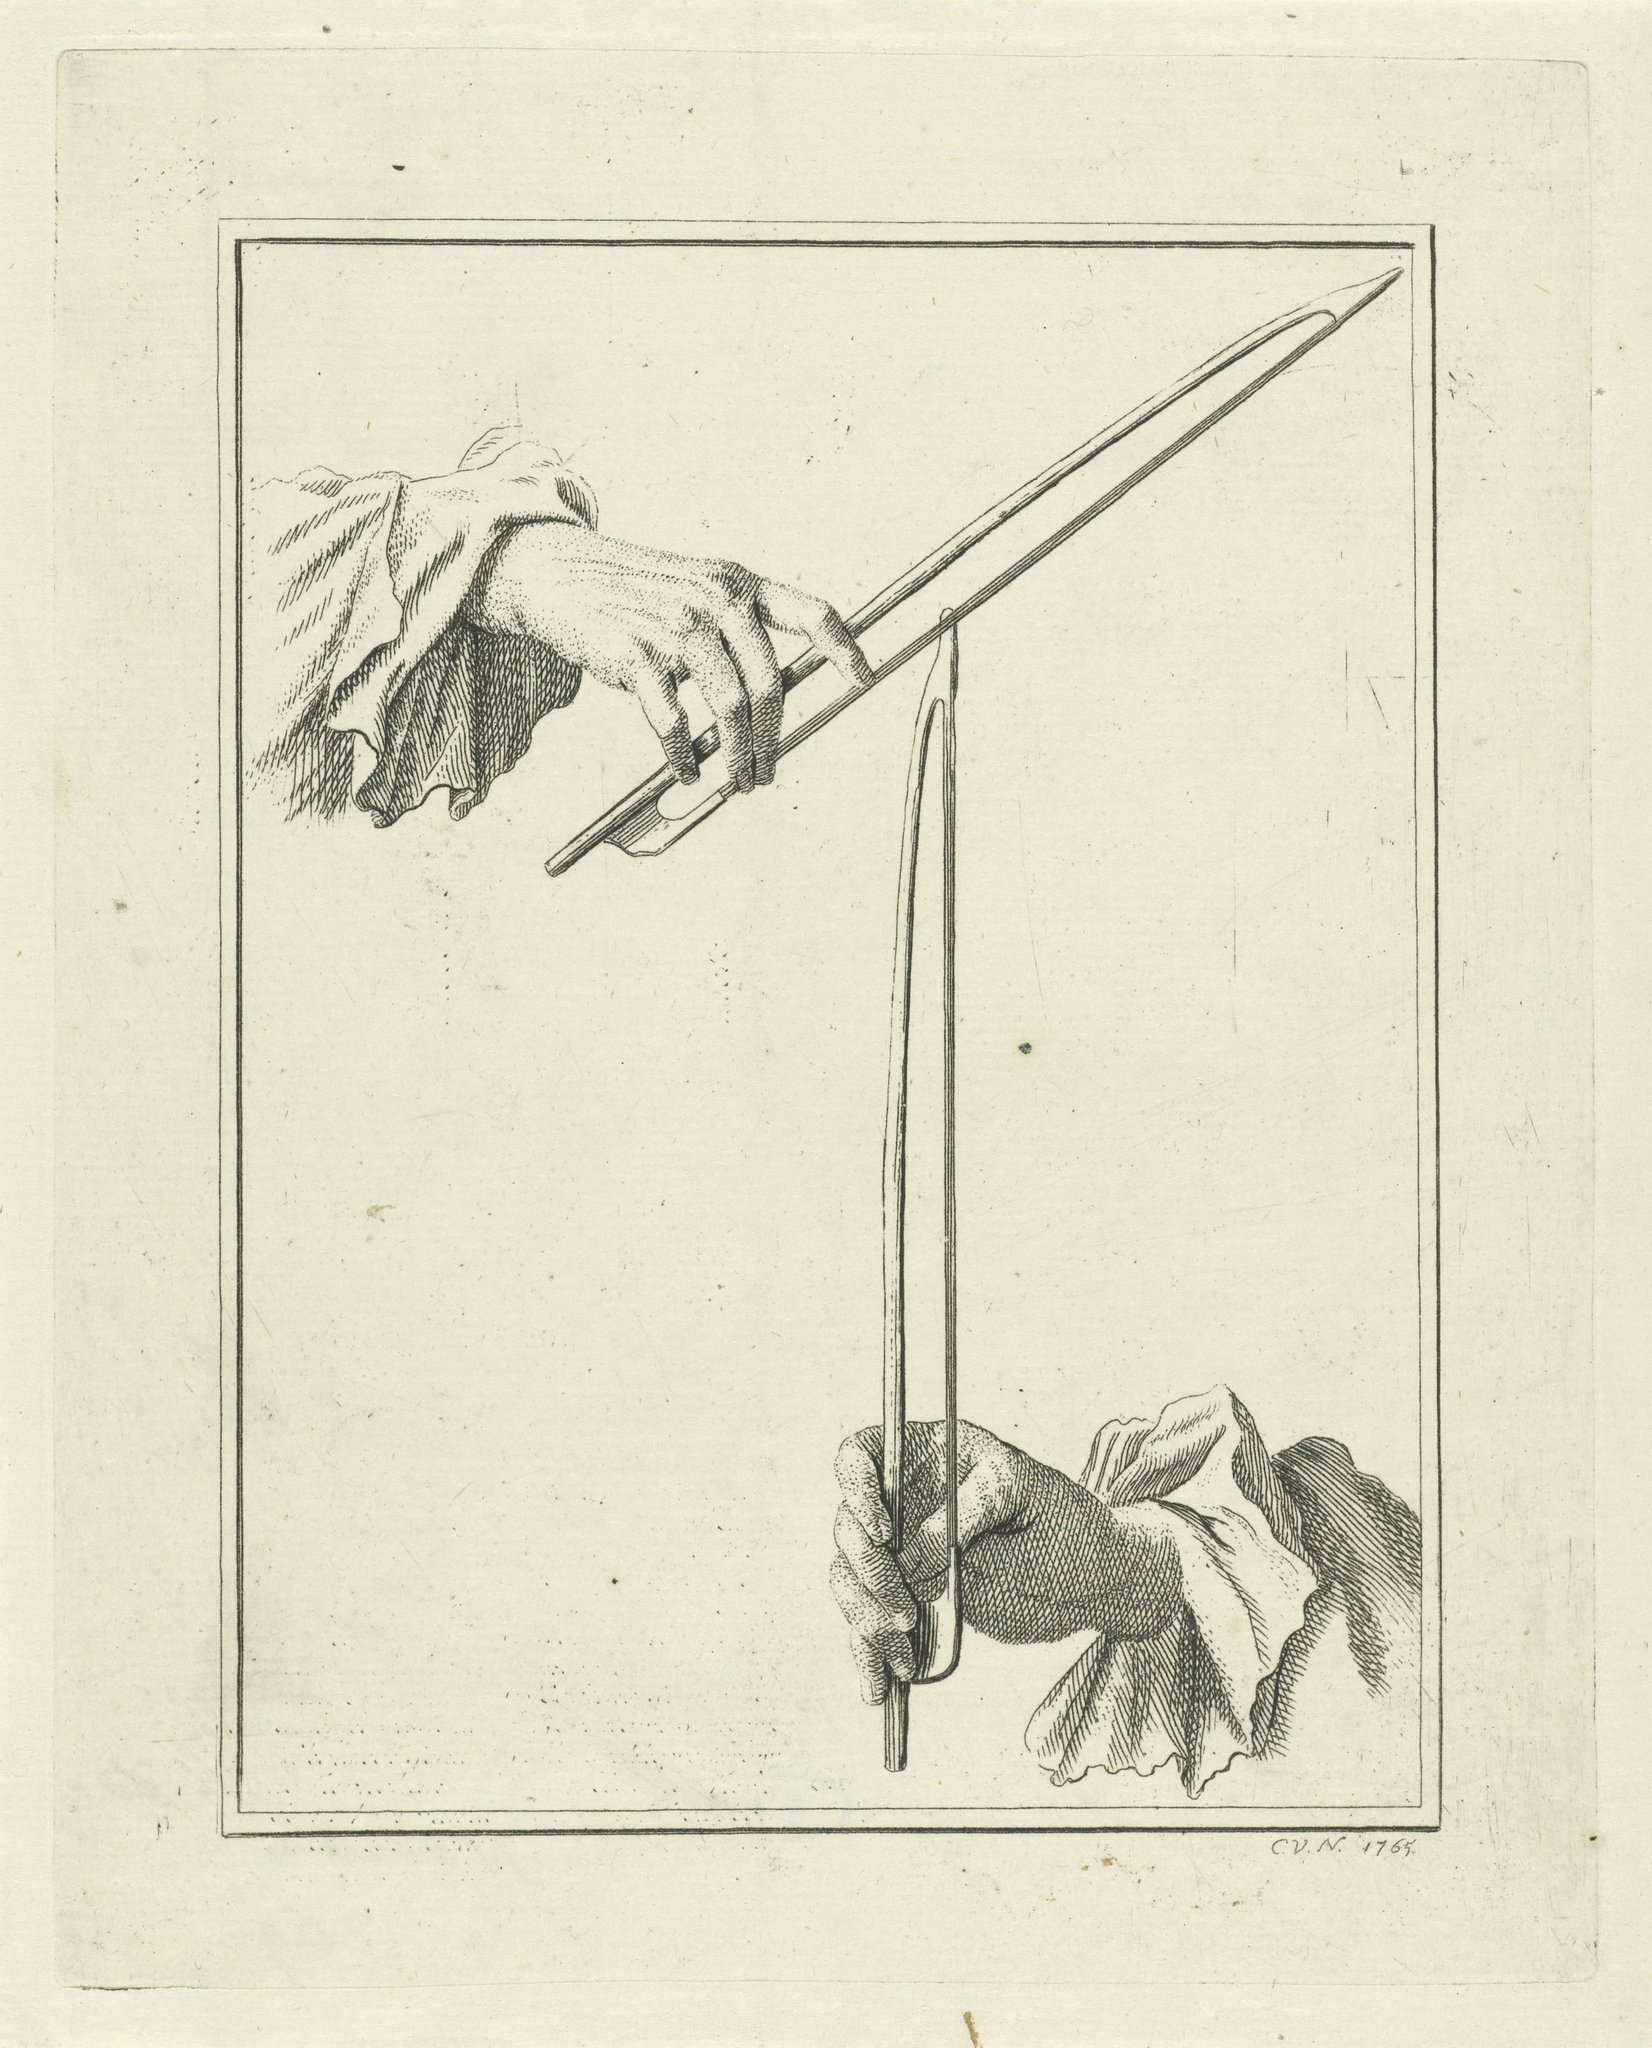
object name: print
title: Strijkstokken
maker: cornelis van noorde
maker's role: draughtsman, print maker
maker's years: 1731-1795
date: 1765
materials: paper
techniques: etching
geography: haarlem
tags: string instruments (bowed)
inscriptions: collector's mark: Lugt 2228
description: Twee rechterhanden, die beiden een strijkstok vasthouden.